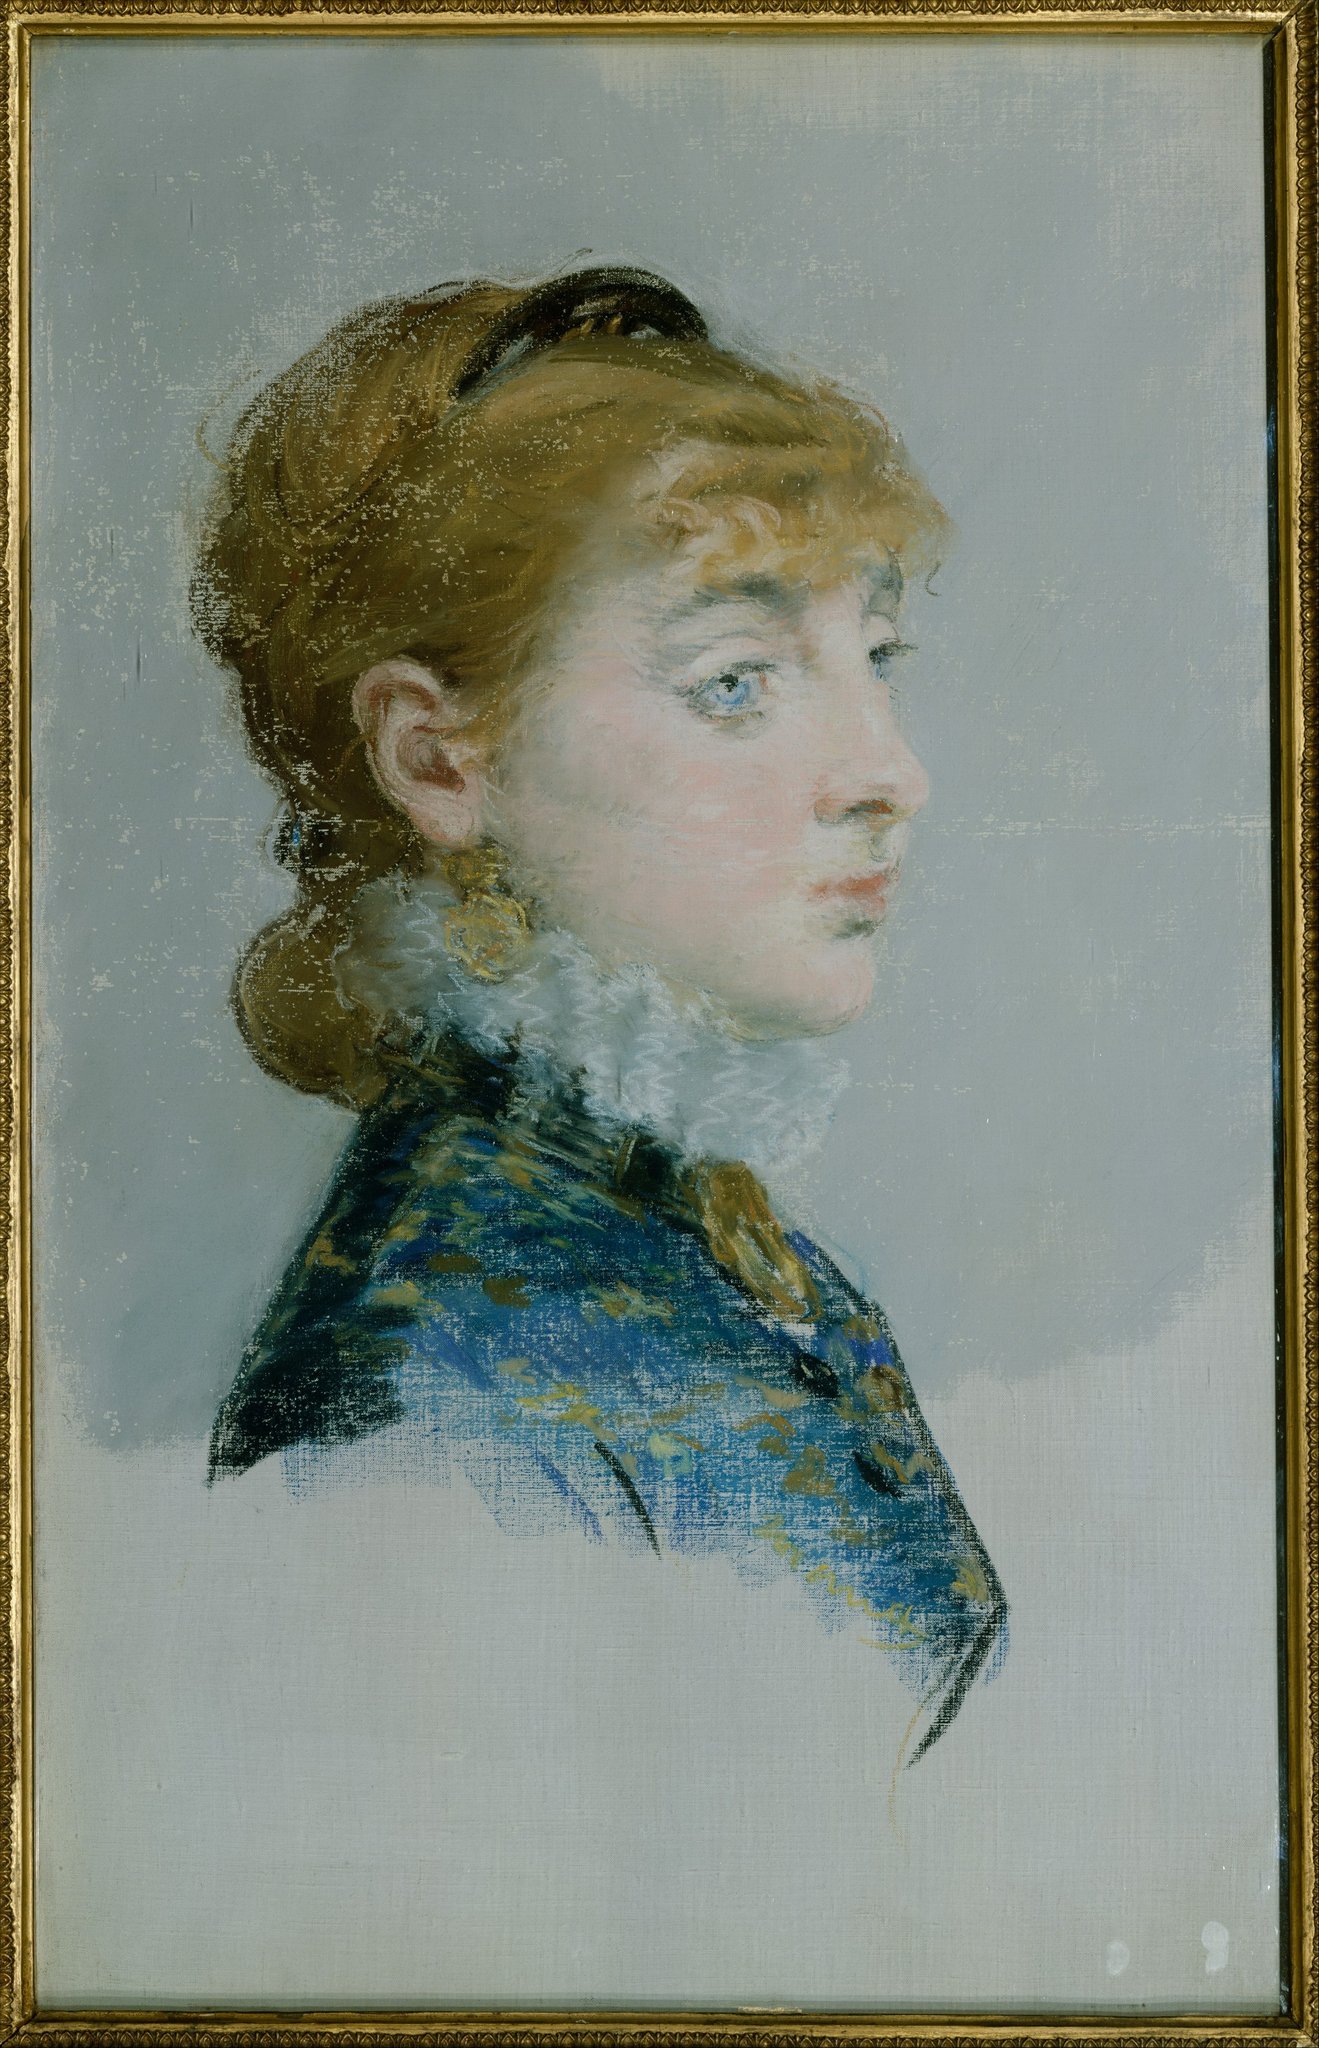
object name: drawing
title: Emilie-Louise Delabigne (1848–1910), Called Valtesse de la Bigne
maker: édouard manet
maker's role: artist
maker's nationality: french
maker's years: 1832-1883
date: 1879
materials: canvas, pastel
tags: portraits,women